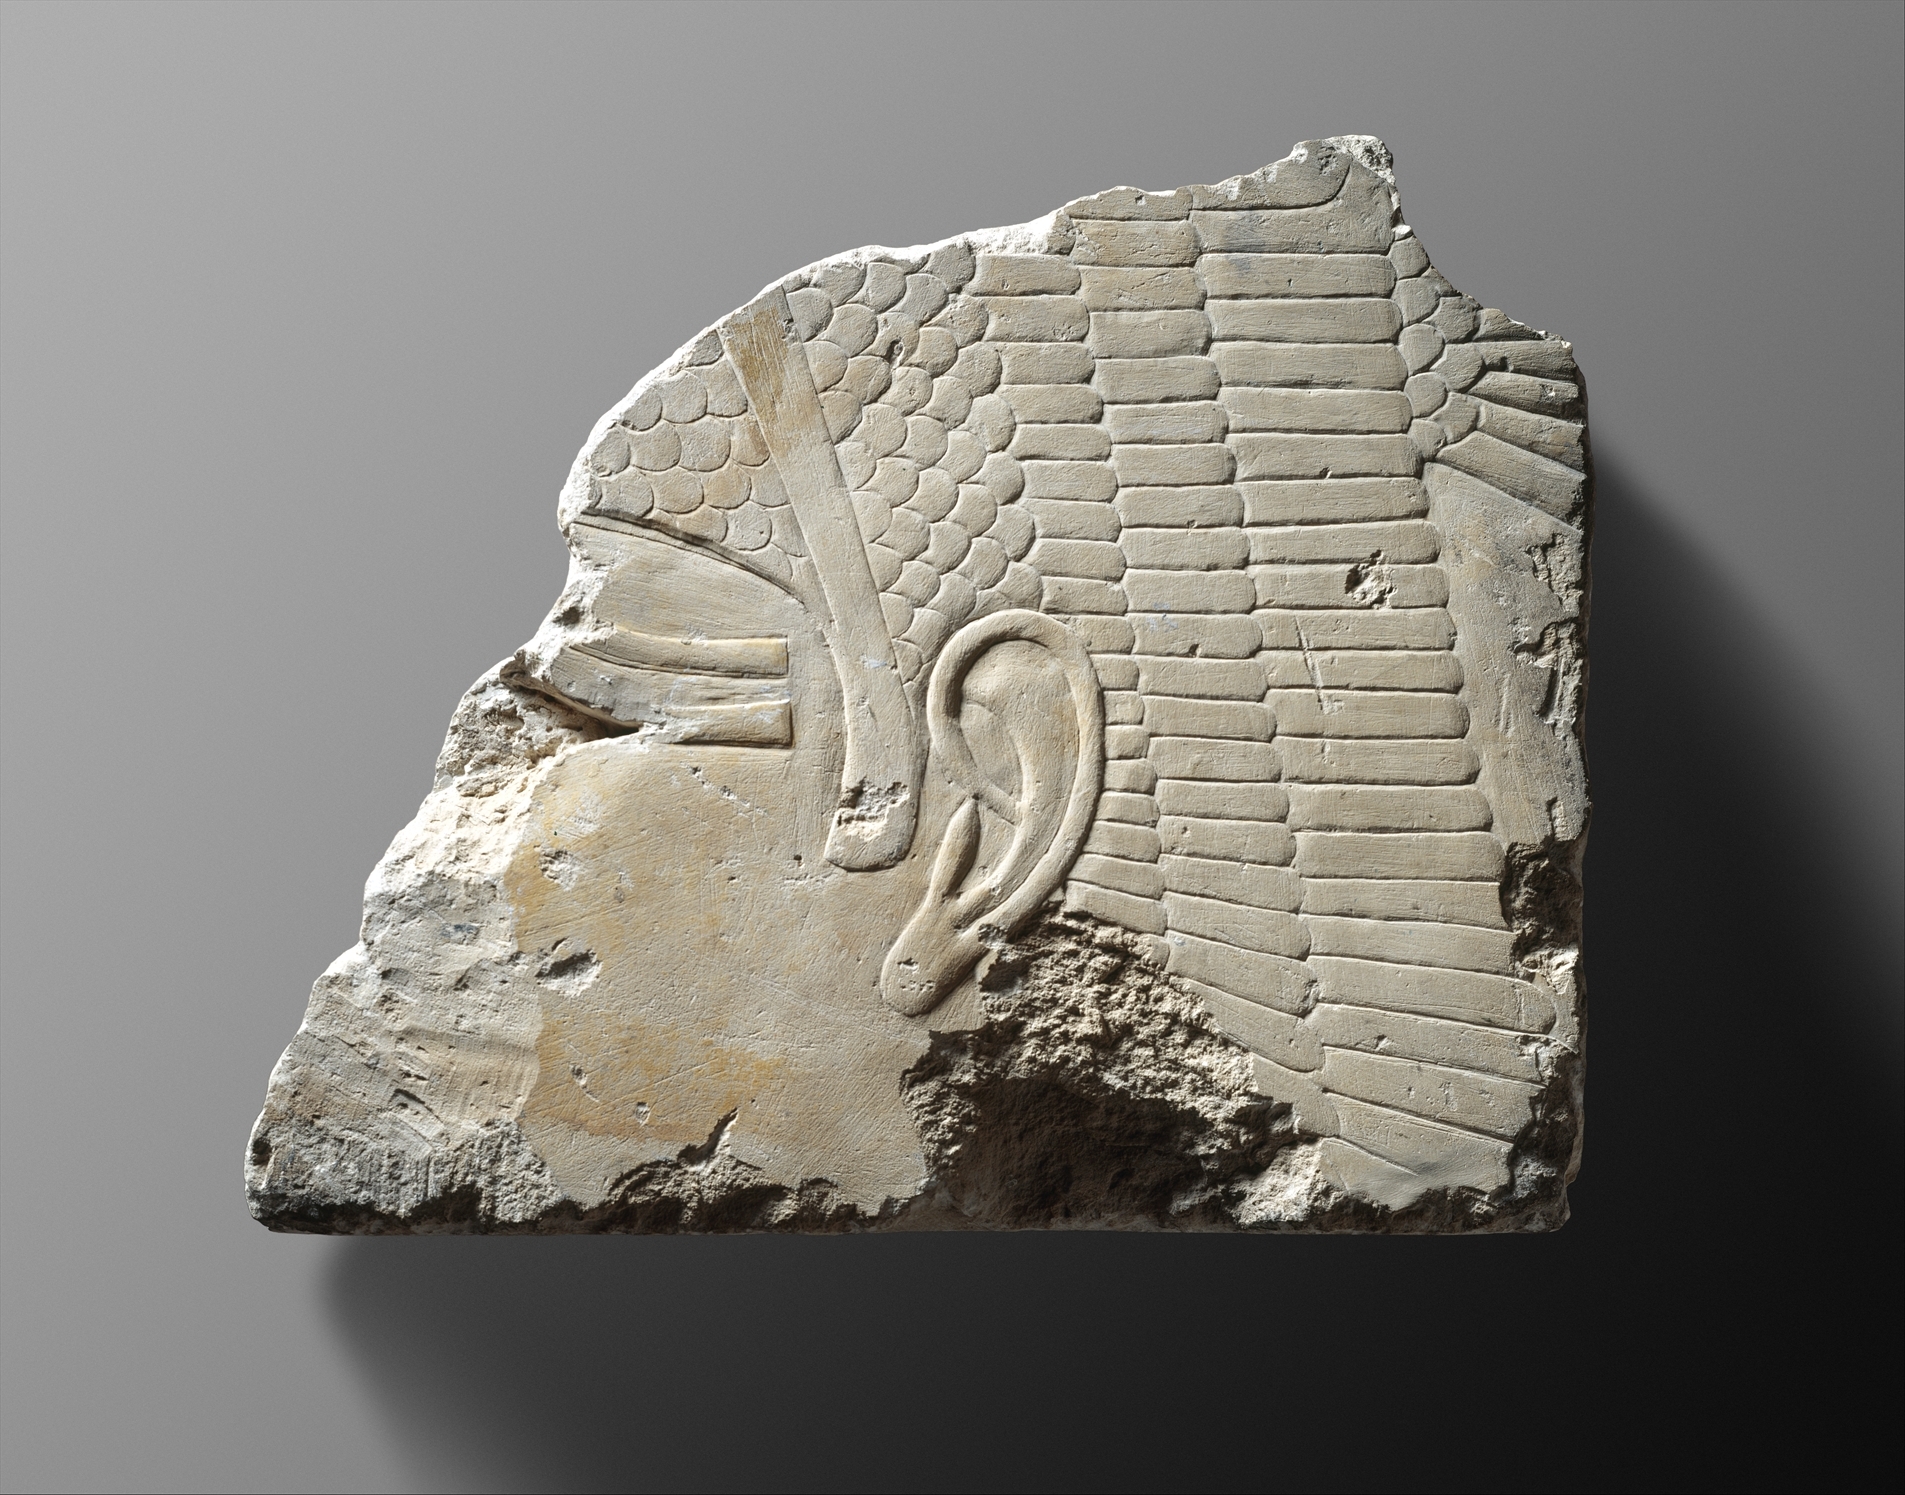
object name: relief, head of a goddess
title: Relief fragment with the head of a goddess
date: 2353-2152 BCE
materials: limestone, paint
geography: egypt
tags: goddess